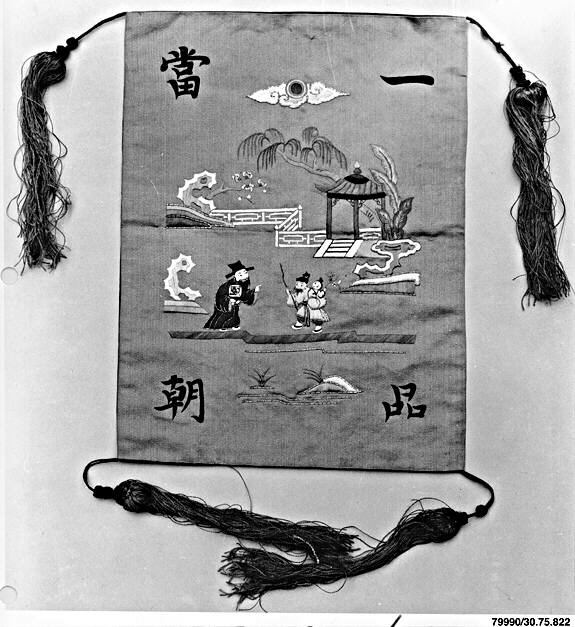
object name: panel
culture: chinese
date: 1644-1911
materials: silk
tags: human figures,landscapes